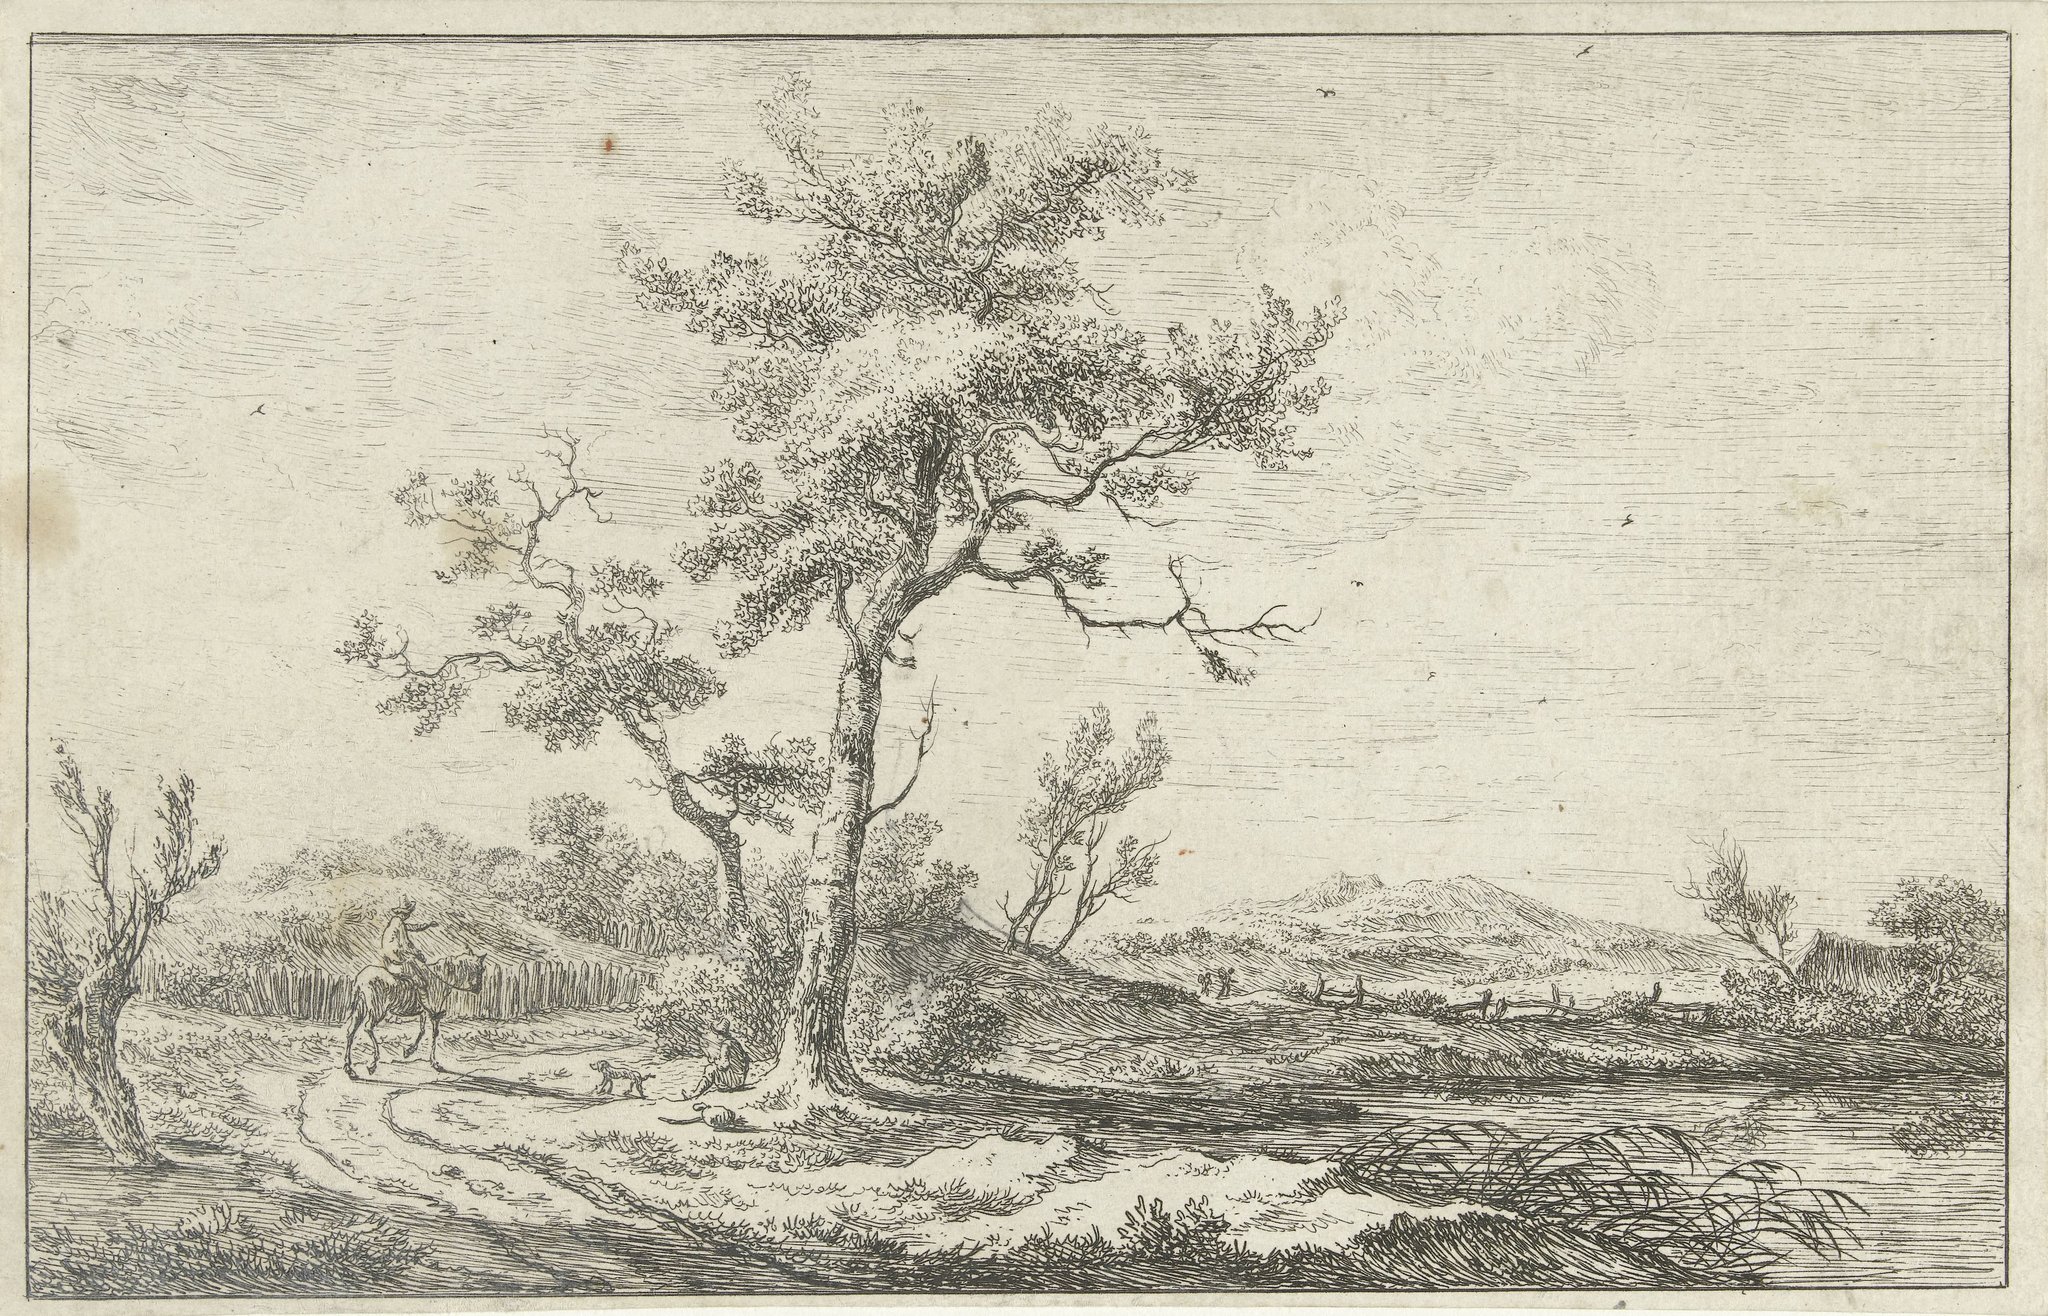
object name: print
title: Ruiter in gesprek op een landweg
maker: carel lodewijk hansen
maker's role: draughtsman, painter, print maker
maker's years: 1765-1840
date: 1780-1840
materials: paper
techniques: etching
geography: netherlands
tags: riding a horse, ass, or mule; rider, horseman, landscapes with waters, waterscapes, seascapes (in the temperate zone) (+ landscape with figures, staffage), dog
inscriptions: collector's mark: Lugt 2228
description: Een ruiter op een landweg, in gesprek met een zittende man met een hond bij een boom.